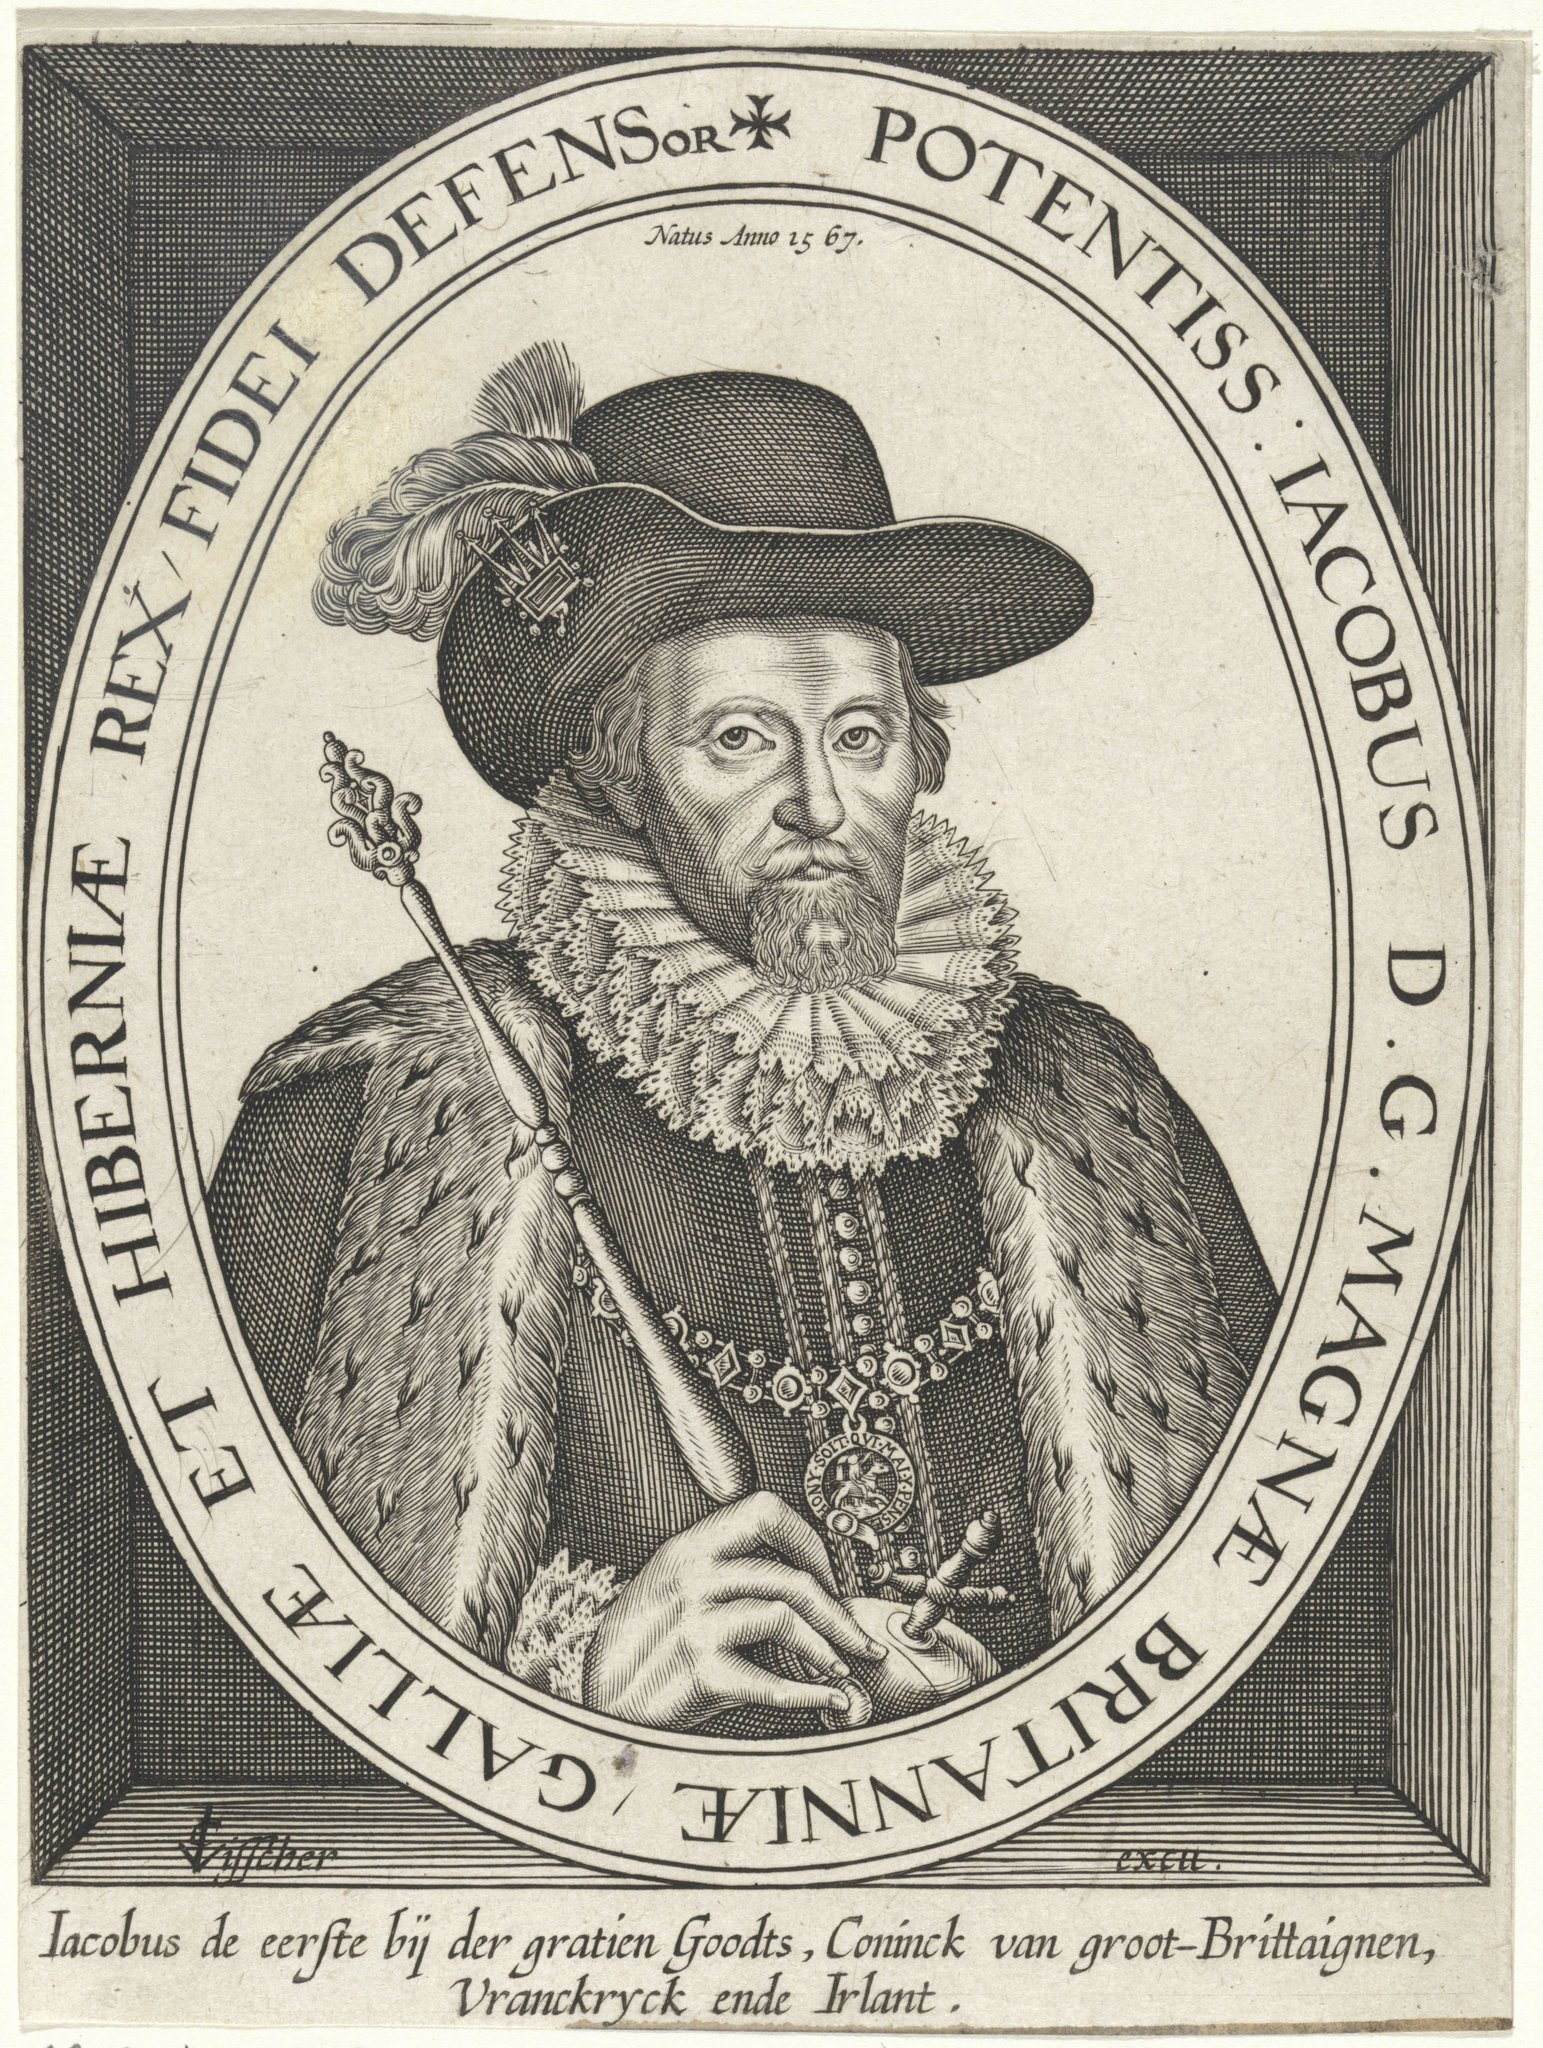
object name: print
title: Portret van Jacobus I van Engeland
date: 1612-1652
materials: paper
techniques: engraving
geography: amsterdam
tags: jacobus i (koning van engeland), knighthood order, head-gear: hat (+ men's clothes)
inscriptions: collector's mark: Lugt 2228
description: Jacobus I van Engeland, met een scepter, een hoed op het hoofd en om zijn hals een keten waaraan het ordeteken van de orde van de Kousenband.